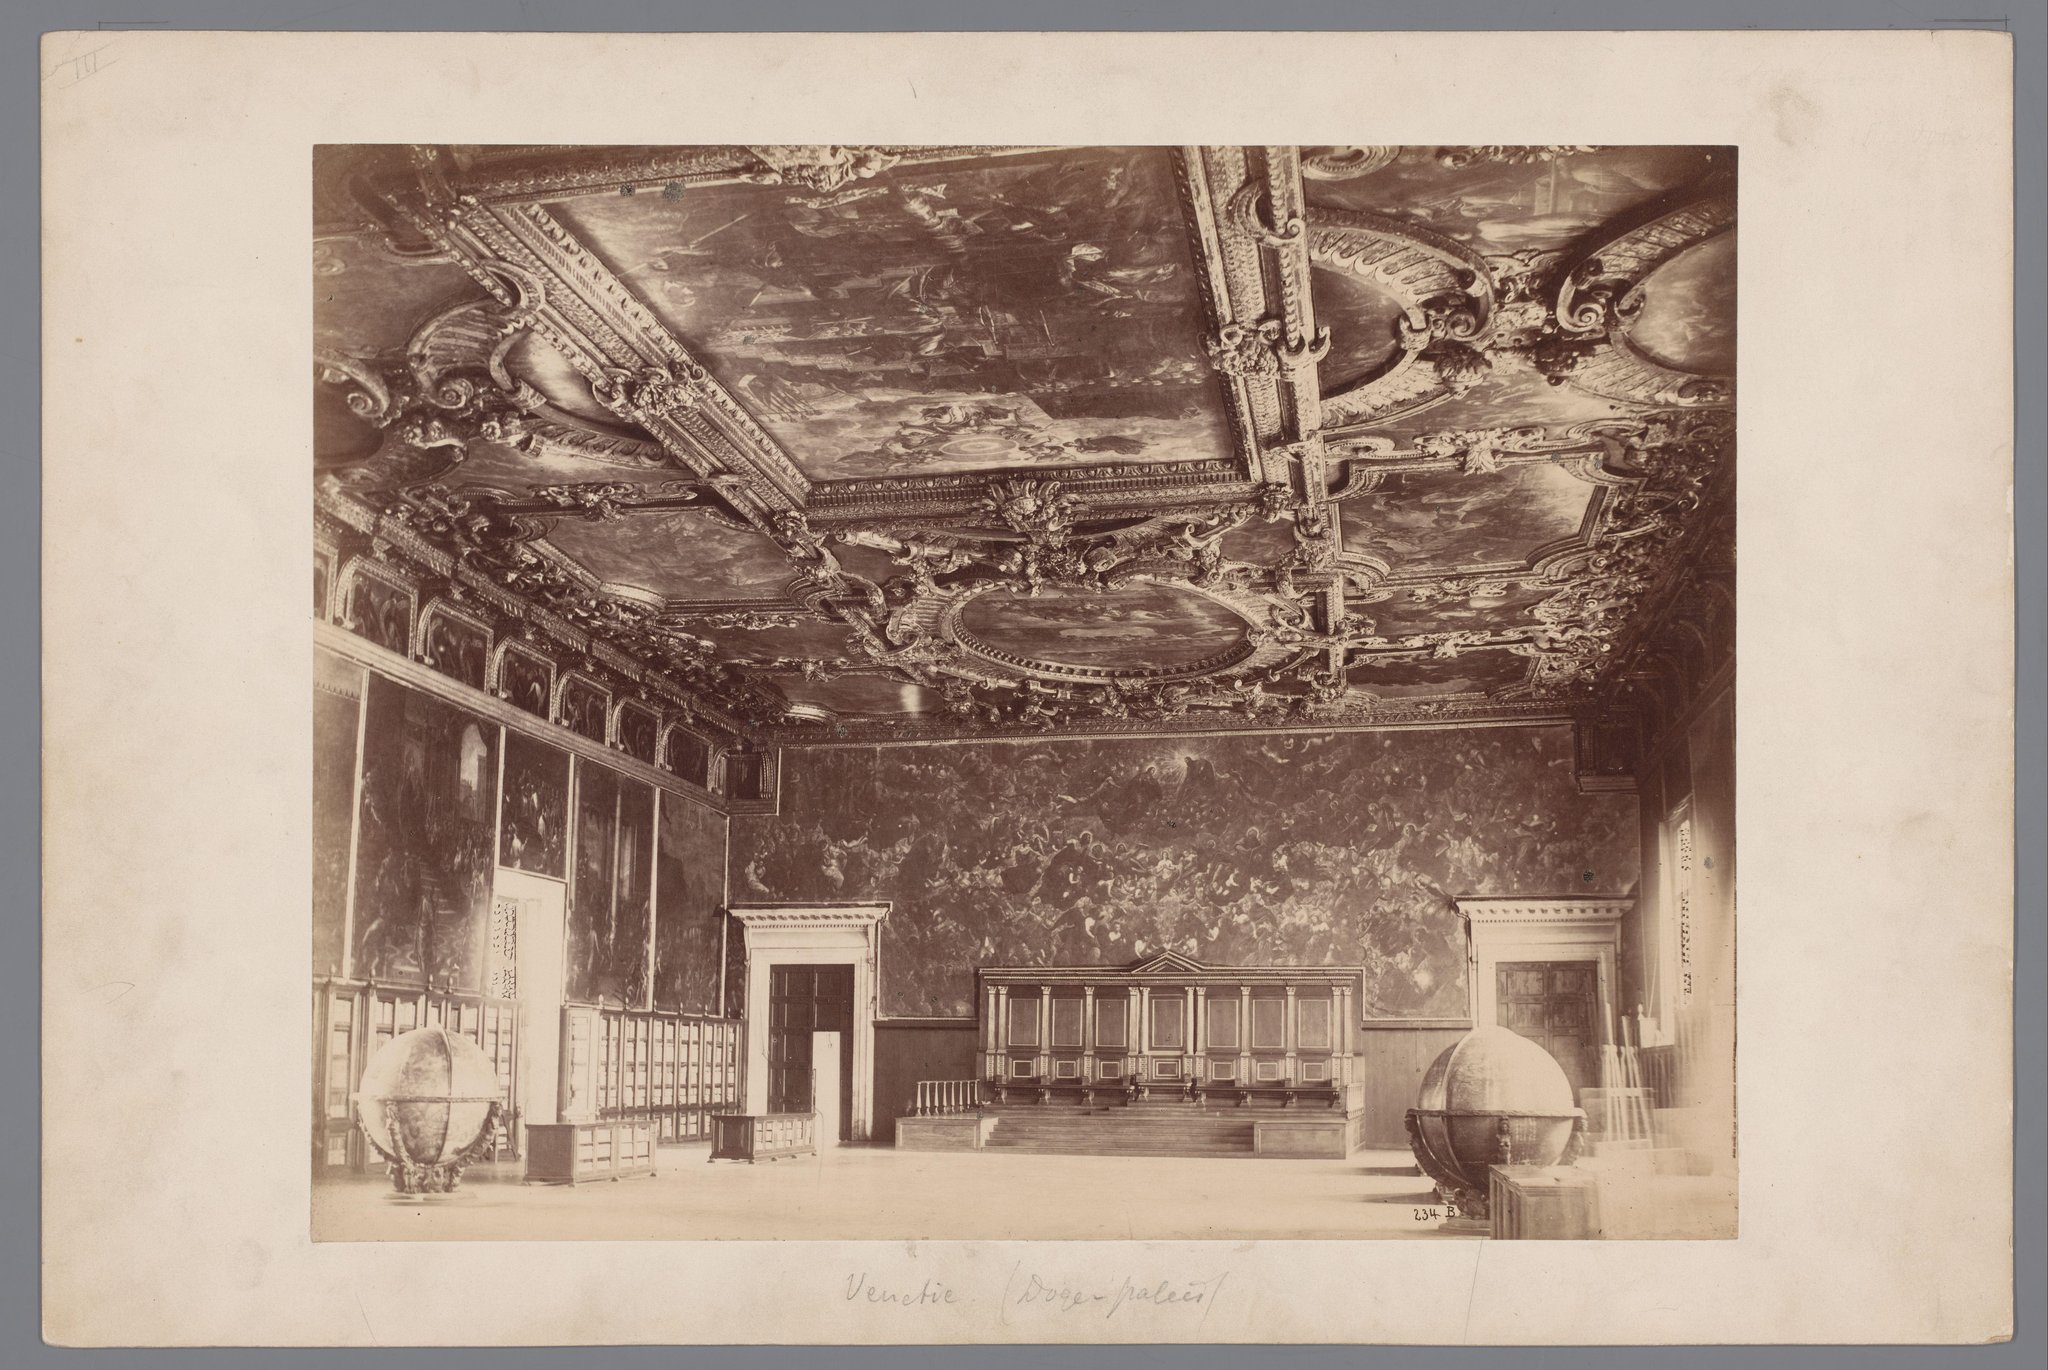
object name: photograph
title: Interieur van een ruimte in het Dogepaleis te Venetië, Italië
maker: Anonymous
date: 1851-1900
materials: cardboard, paper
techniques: albumen print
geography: venice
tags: palace, interior ~ representation of a building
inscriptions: inscription: ‘RSKW [?]’, collector's mark: ‘RIJKS SCHOOL VOOR KUNSTNIJVERHEID/ GROEP’, inscription: ‘III’, number: ‘234B’